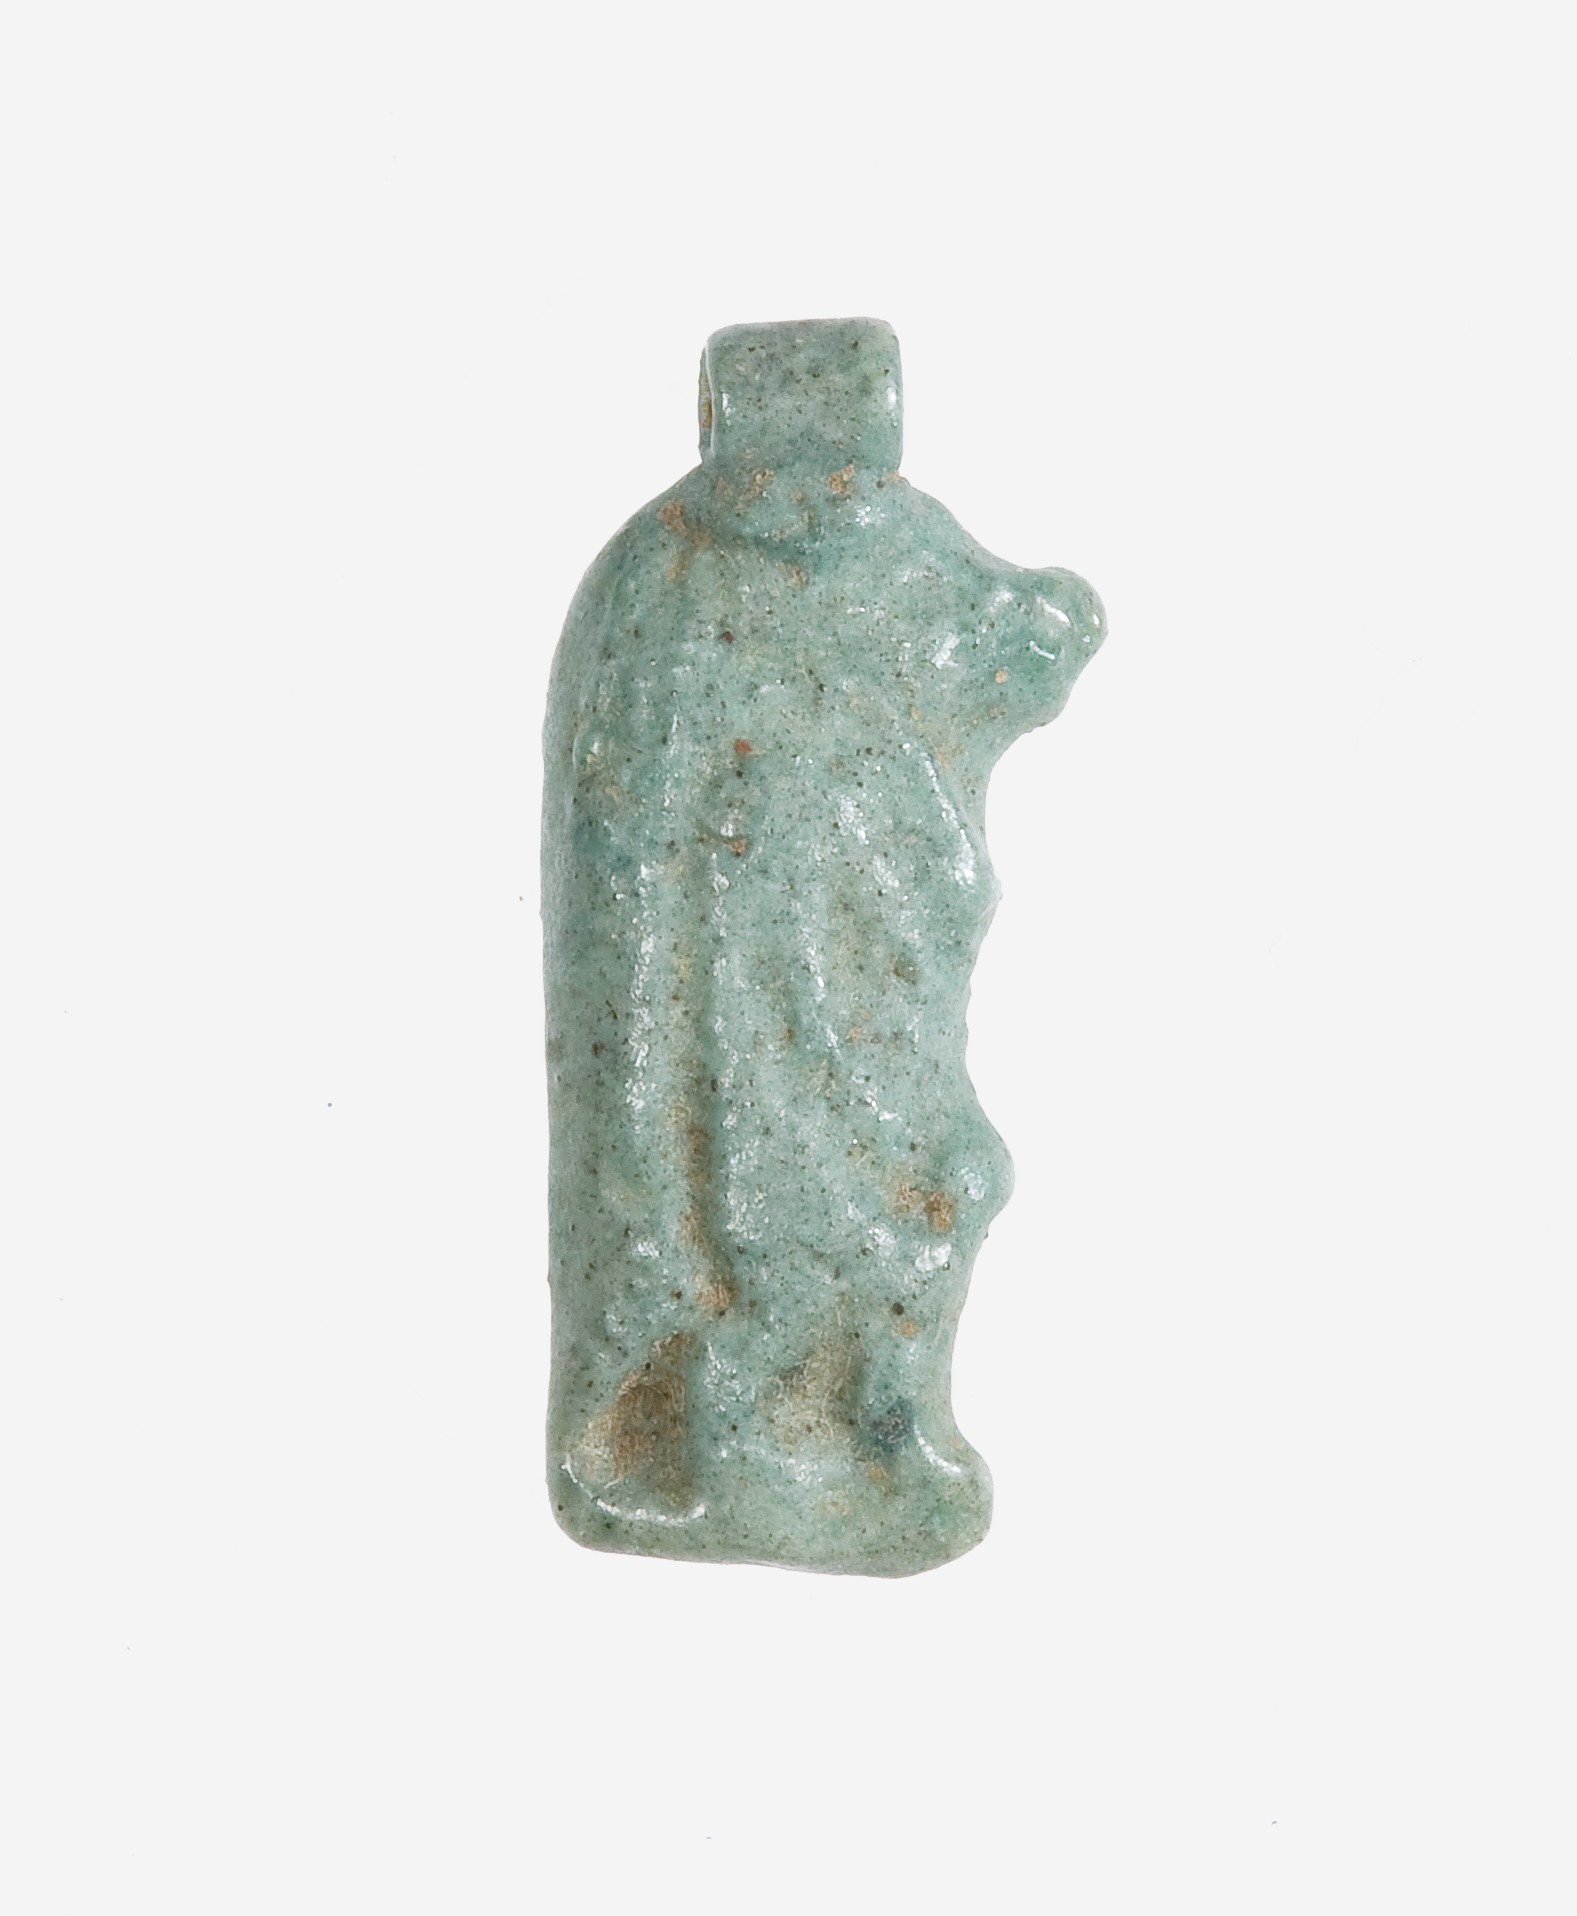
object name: amulet, taweret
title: Amulet: Taweret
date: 1390-1352 BCE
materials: faience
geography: egypt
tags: taweret